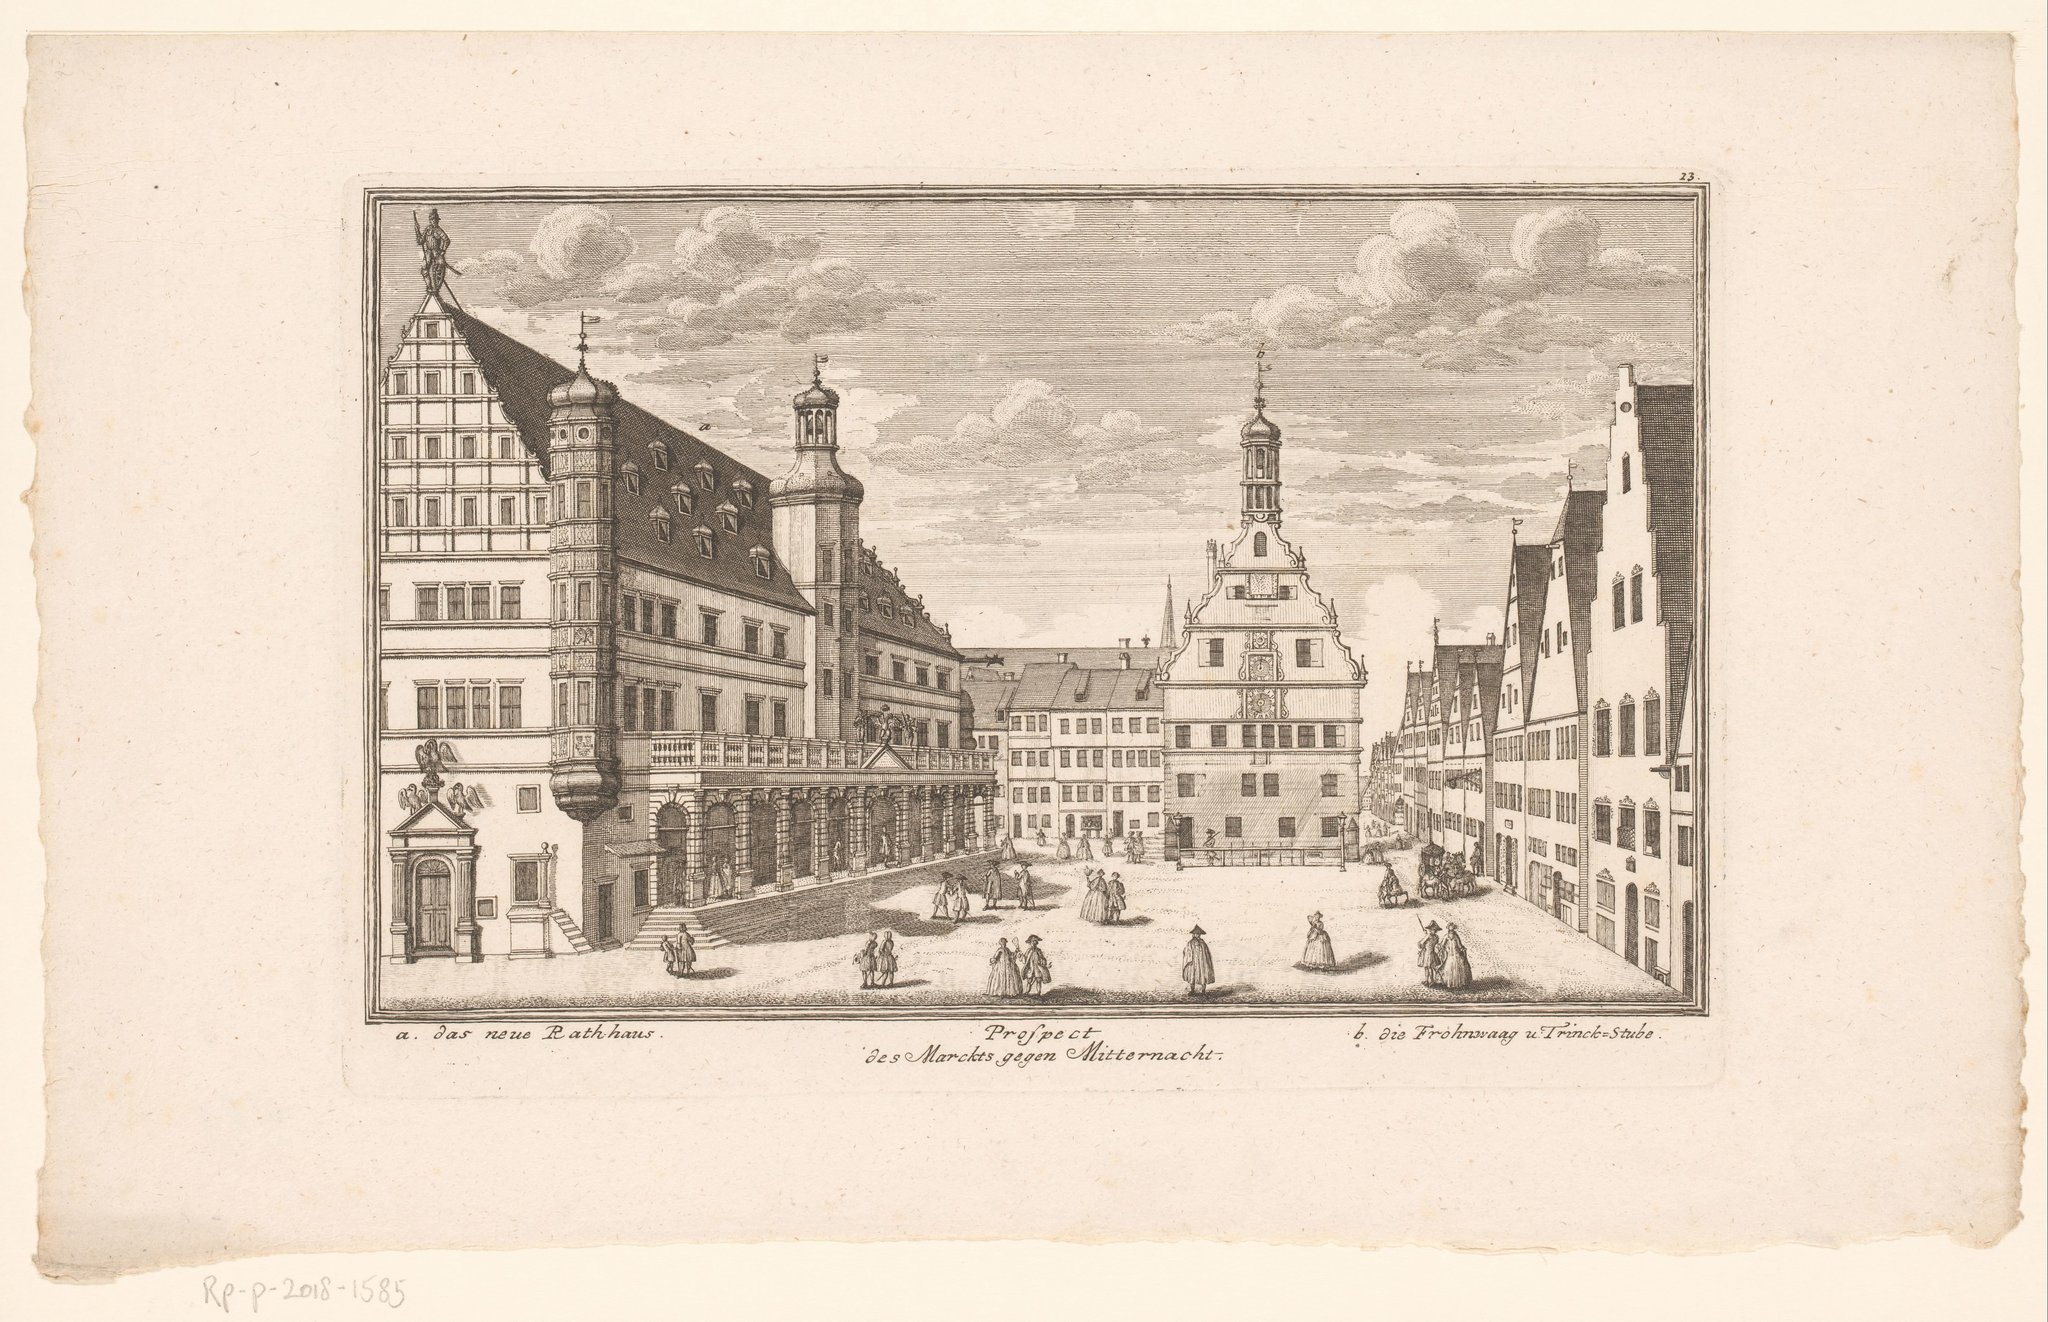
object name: print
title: Prospect des Marckts gegen Abend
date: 1758-1796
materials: paper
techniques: engraving, etching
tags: square, place, circus, etc., townhall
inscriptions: collector's mark: Lugt 2228